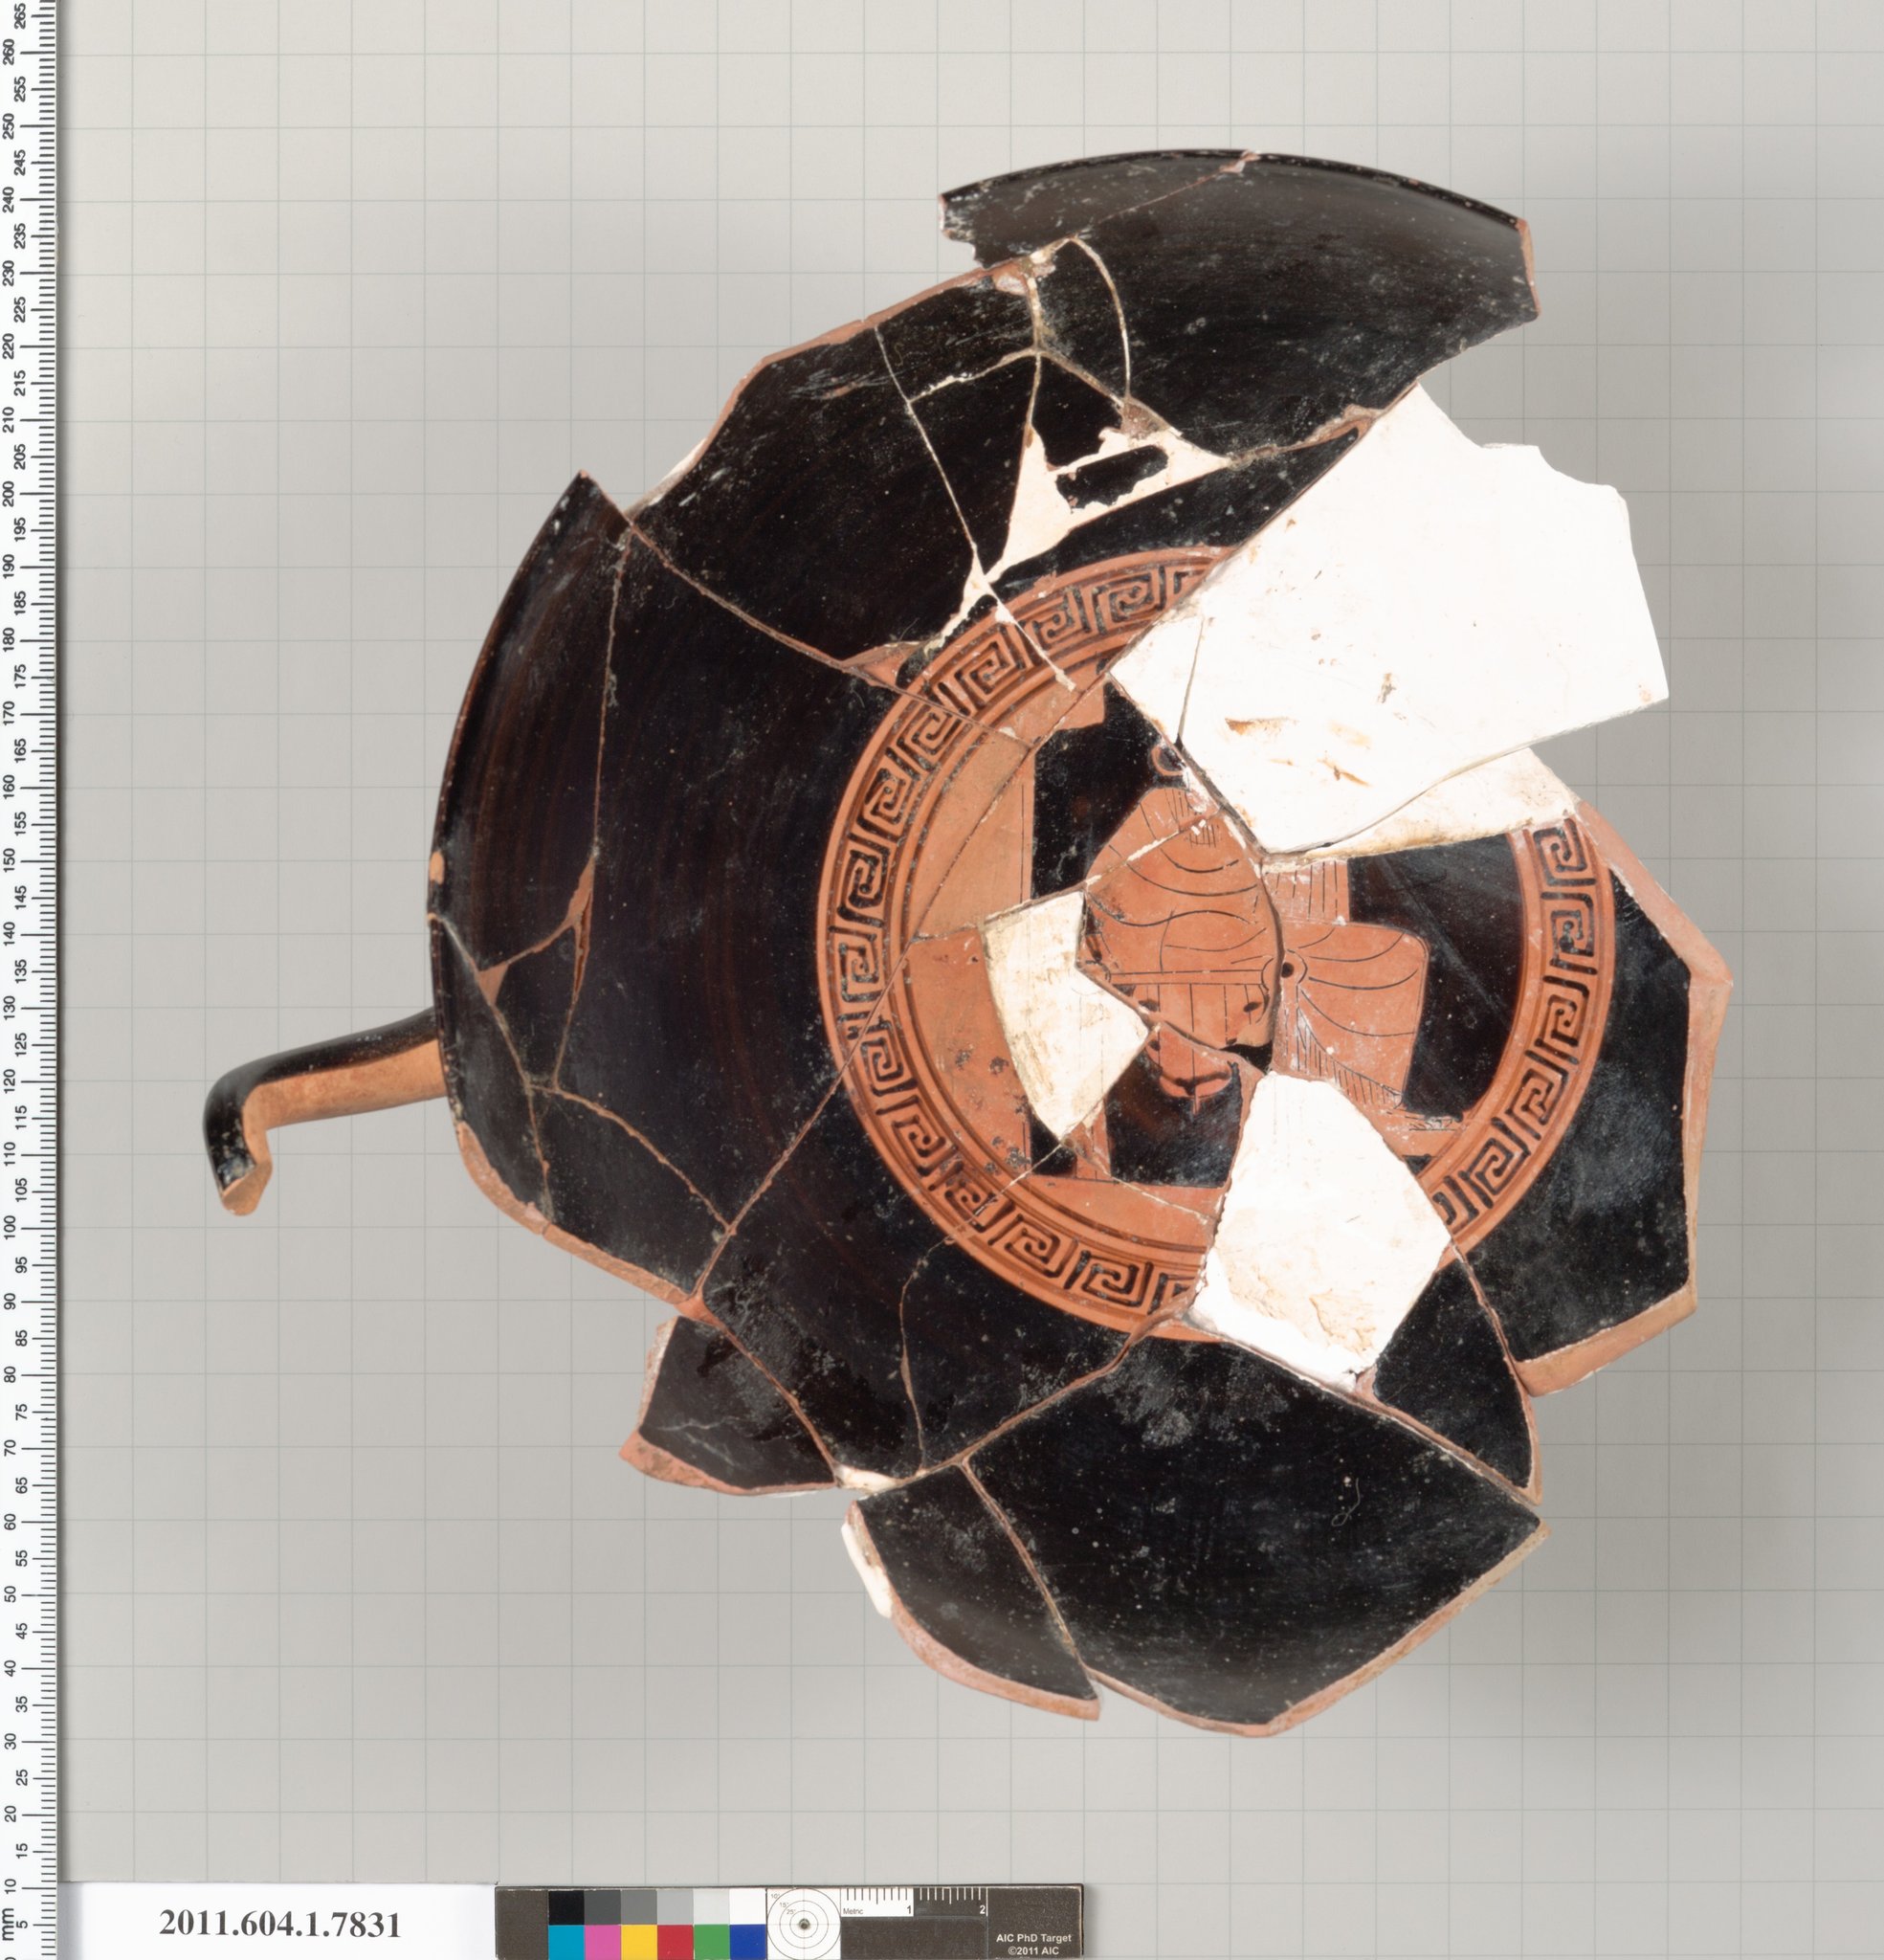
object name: kylix fragment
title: Terracotta fragment of a kylix (drinking cup)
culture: greek, attic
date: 460-450 BCE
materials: terracotta